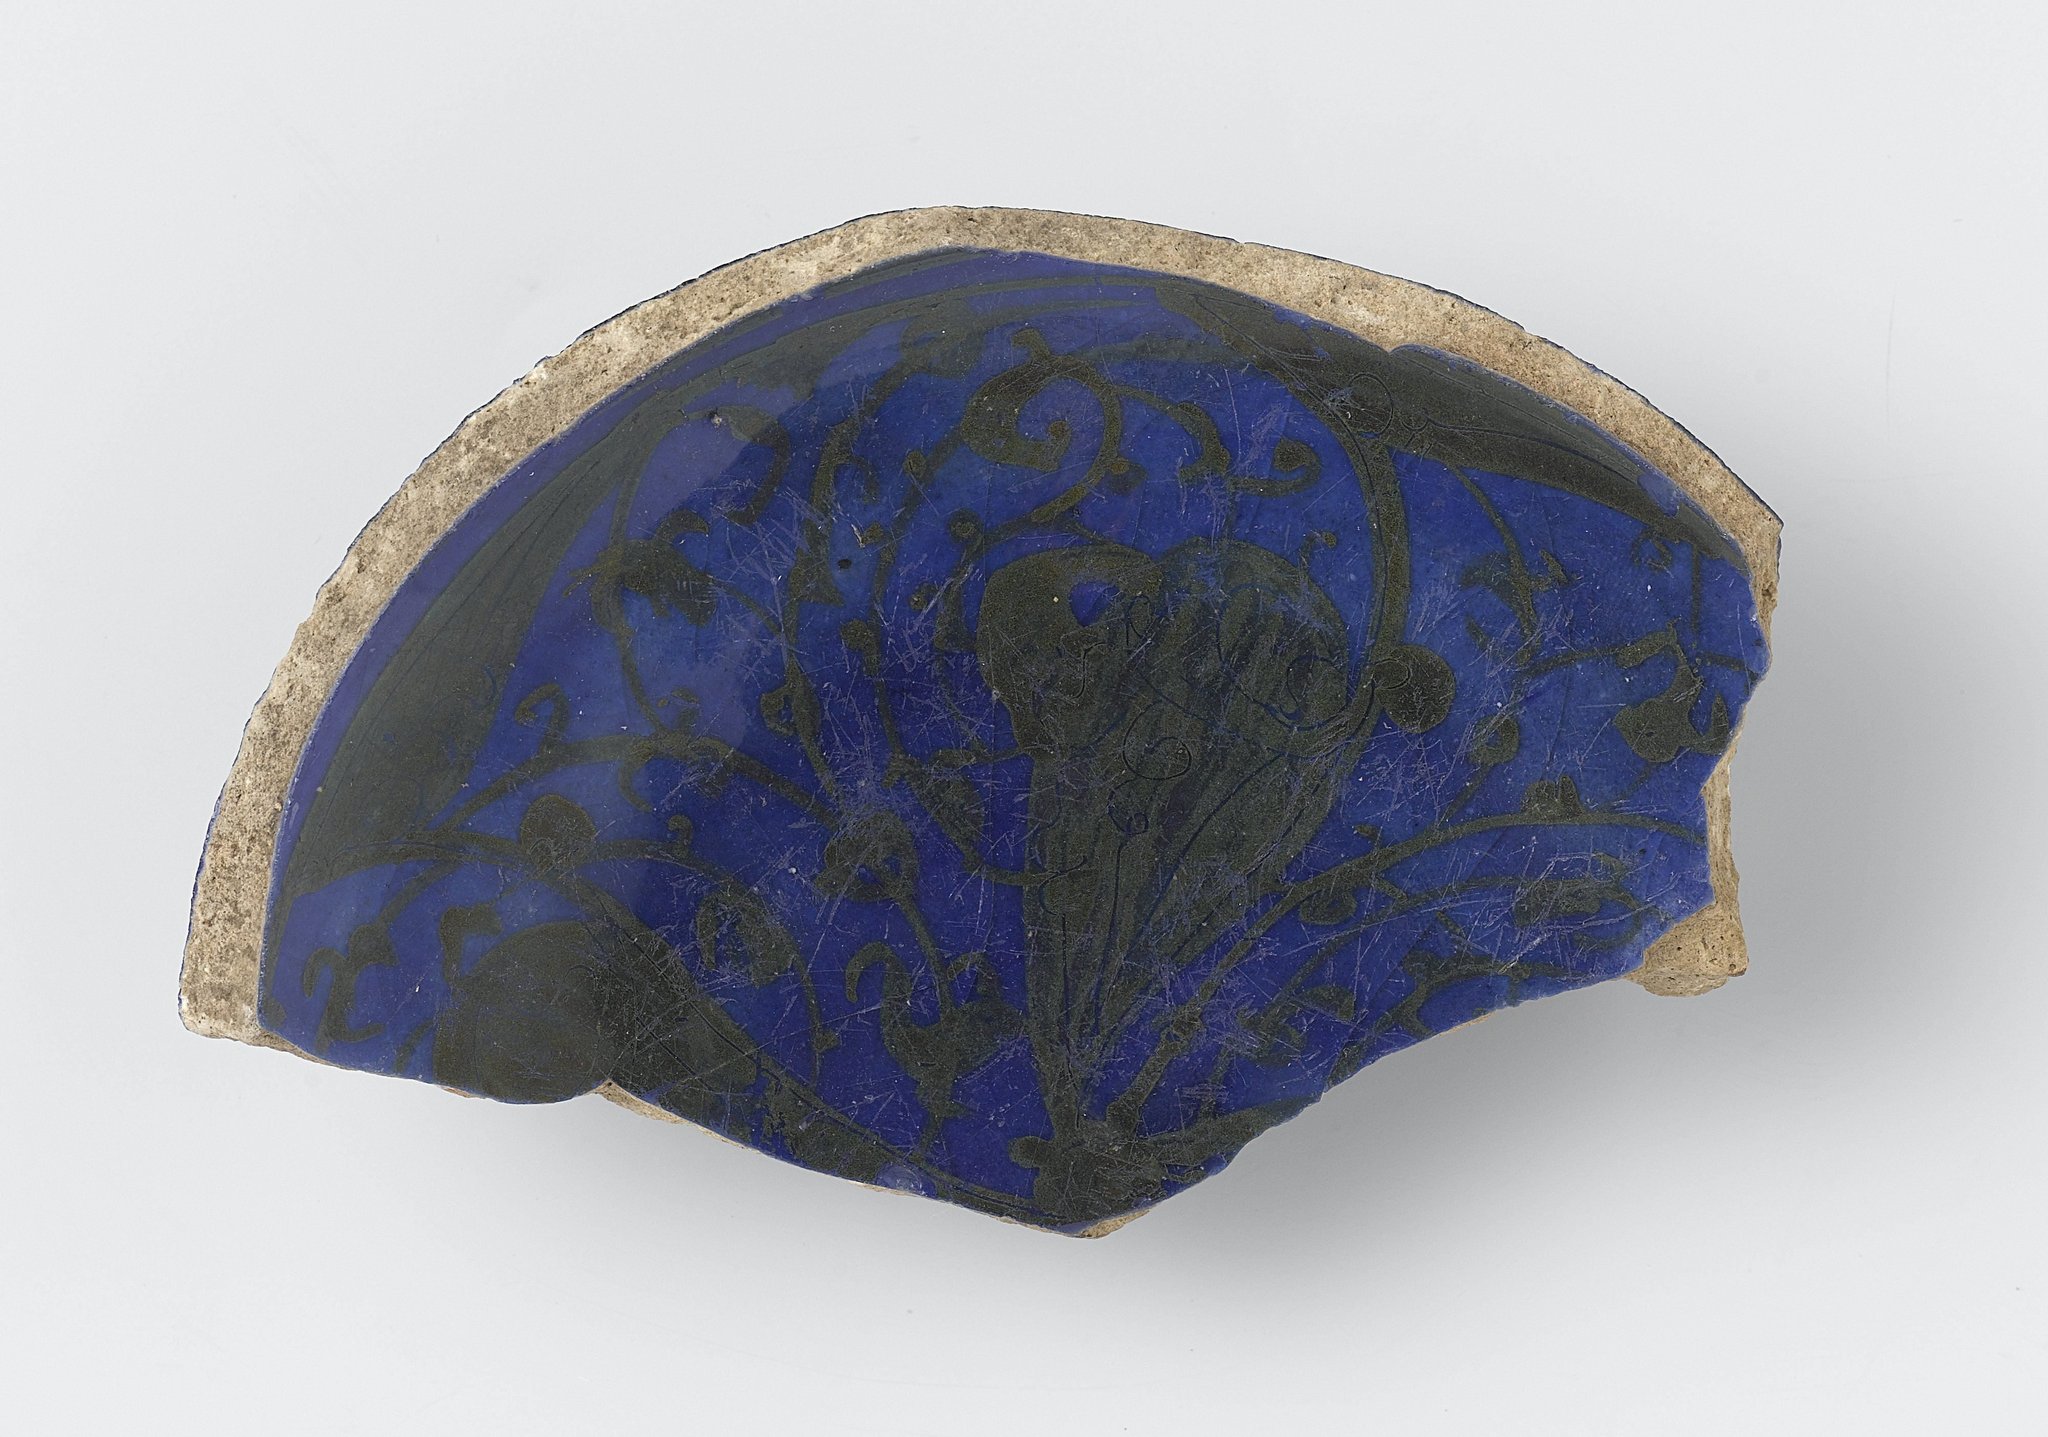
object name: fragment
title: Dish fragment with floral scrolls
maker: Anonymous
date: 1200-1299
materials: earthenware, glaze, luster, paint, quartz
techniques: firing, turning, vitrification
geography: syria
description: Fragment van een schotel van kwarts-fritgoed met bloemranken in olijfgroen luster. Tamelijk harde witte aarde met doorschijnend blauw glazuur.